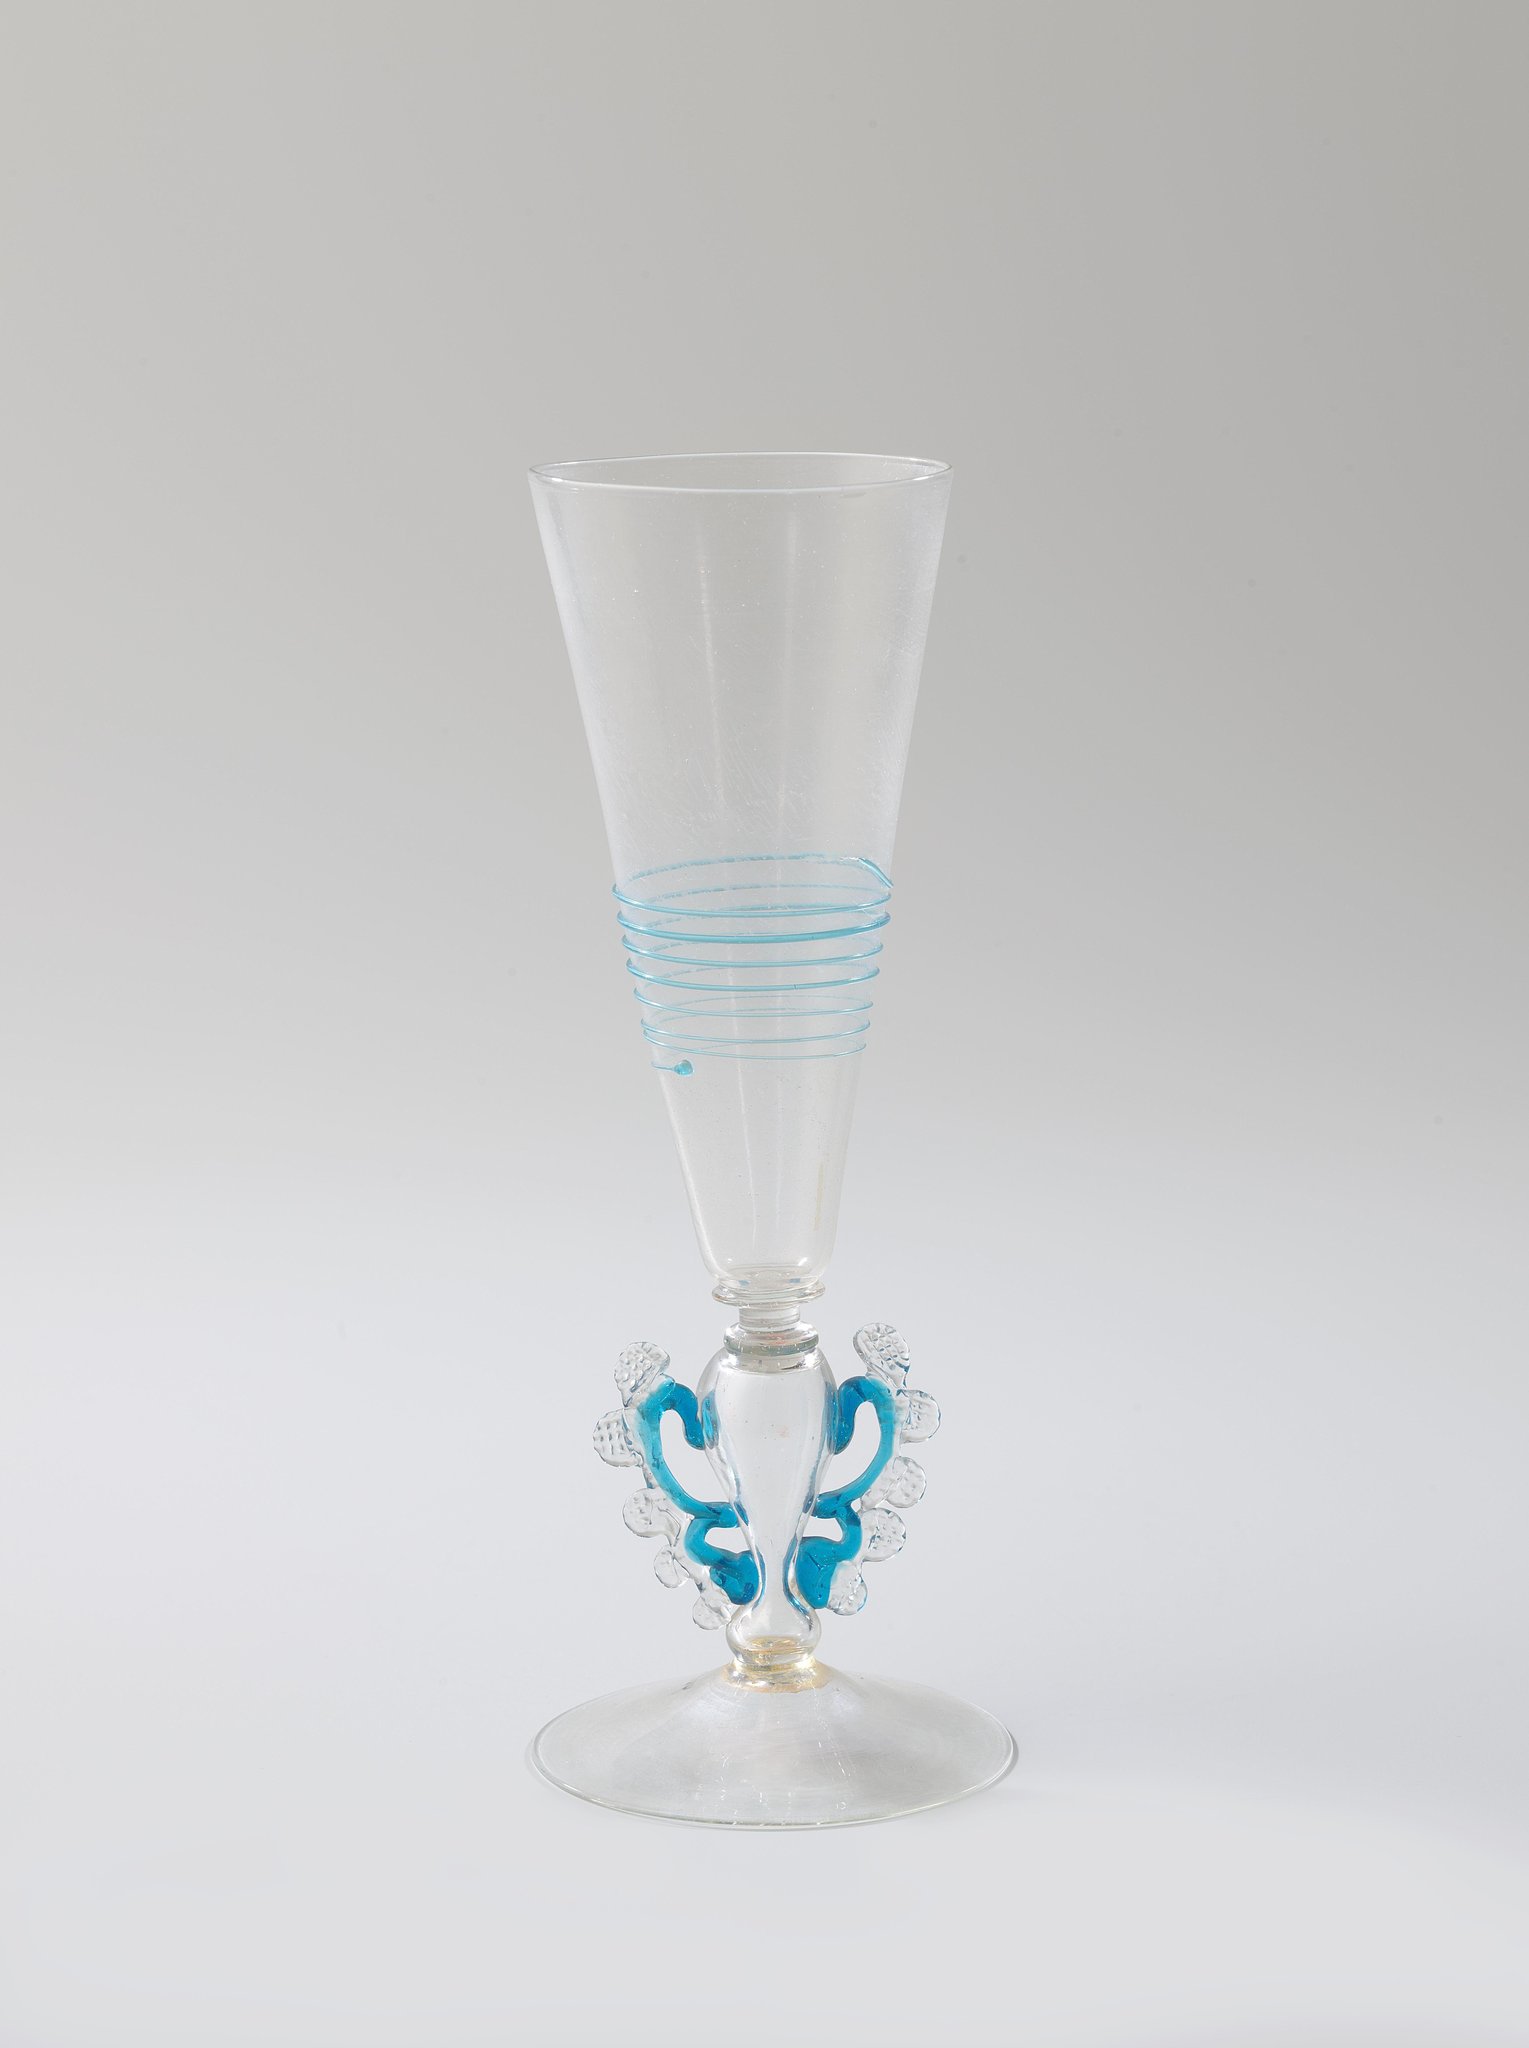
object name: goblet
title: Vleugelglas met blauwe spiraaldraad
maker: Anonymous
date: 1800-1900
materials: glass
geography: venice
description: Vleugelglas op platte voet, balustervormige stam met twee blauwe vleugels bezet met tien platte wafeltjes. De hoge, trechtervormige kelk is versierd met een blauwe spiraaldraad.